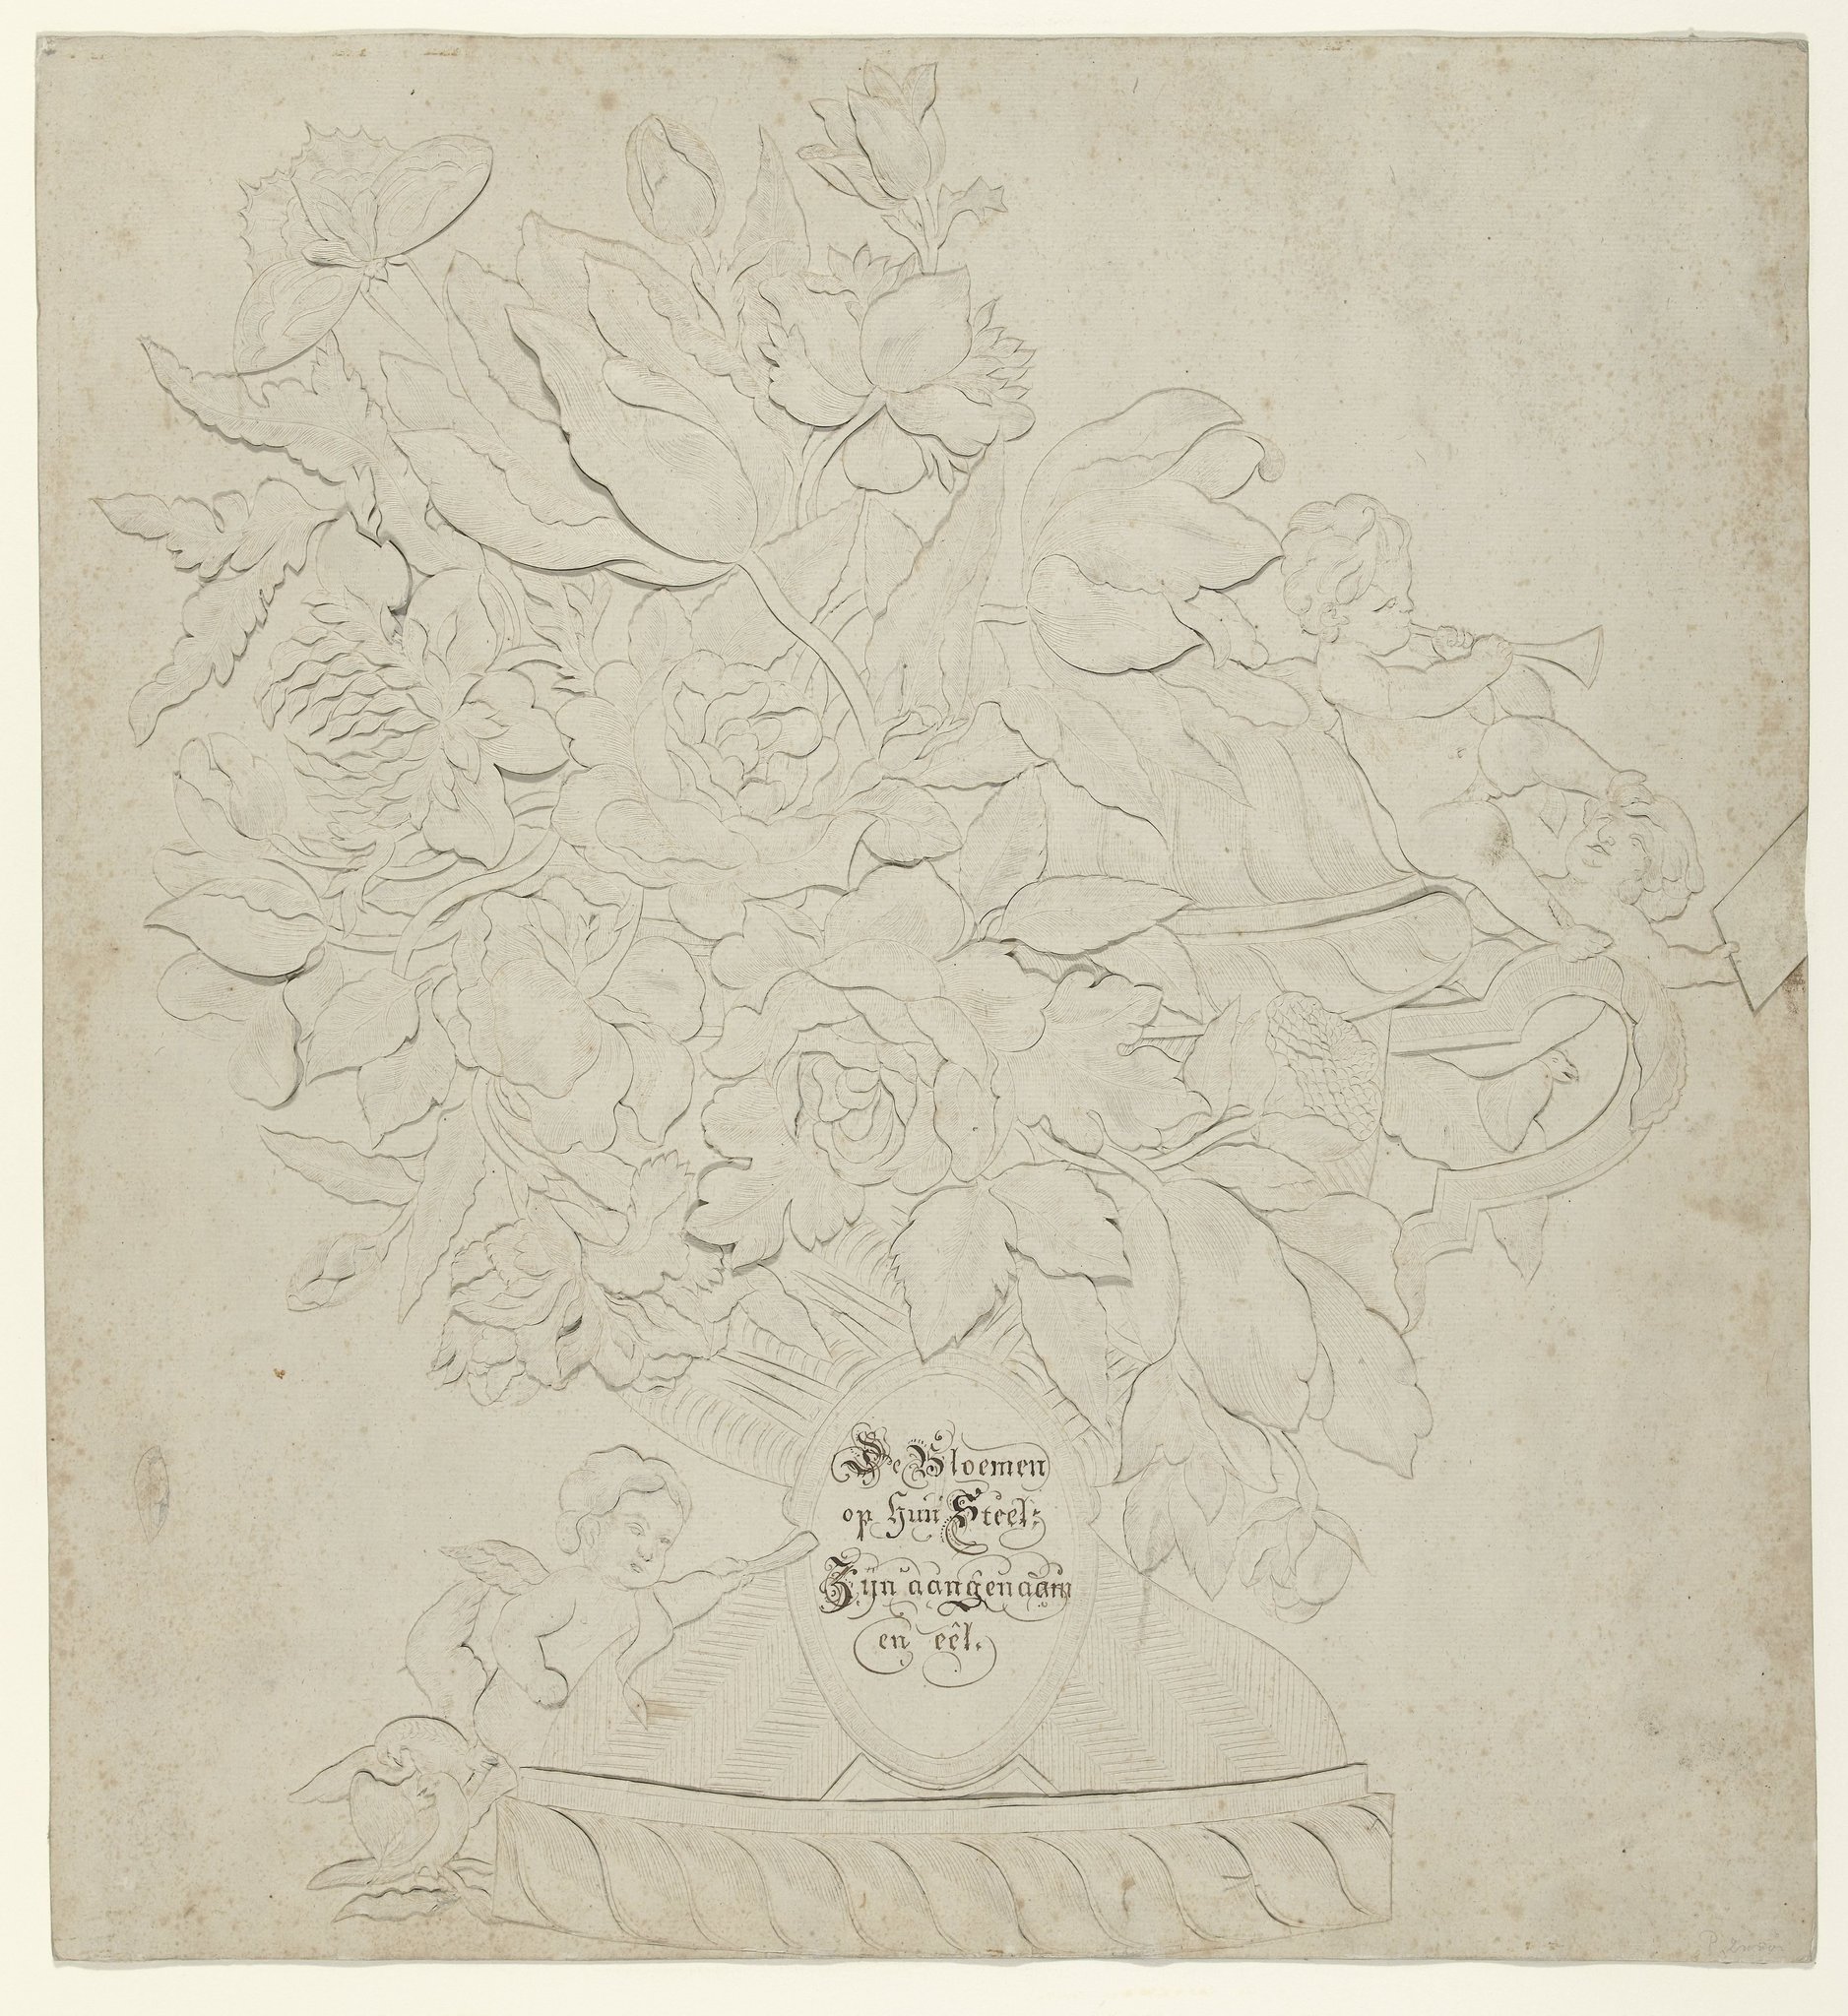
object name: cut paper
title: Bloemstuk met putti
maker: Anonymous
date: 1700-1800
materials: ink, paper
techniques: cutting, snipping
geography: south holland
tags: flowers in a vase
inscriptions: signature: ‘P. Zw[?]ur’, : ‘De Bloemen op hun Steel zijn aangenaam en eêl.’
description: Knipkunstwerk met bloemen in een vaas, drie putti en een cartouche met de tekst: ‘De bloemen op hun steel zijn aangenaam en eêl.'